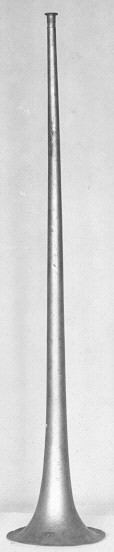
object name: trumpet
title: Speaking Trumpet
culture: european or american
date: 1801-1833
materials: brass